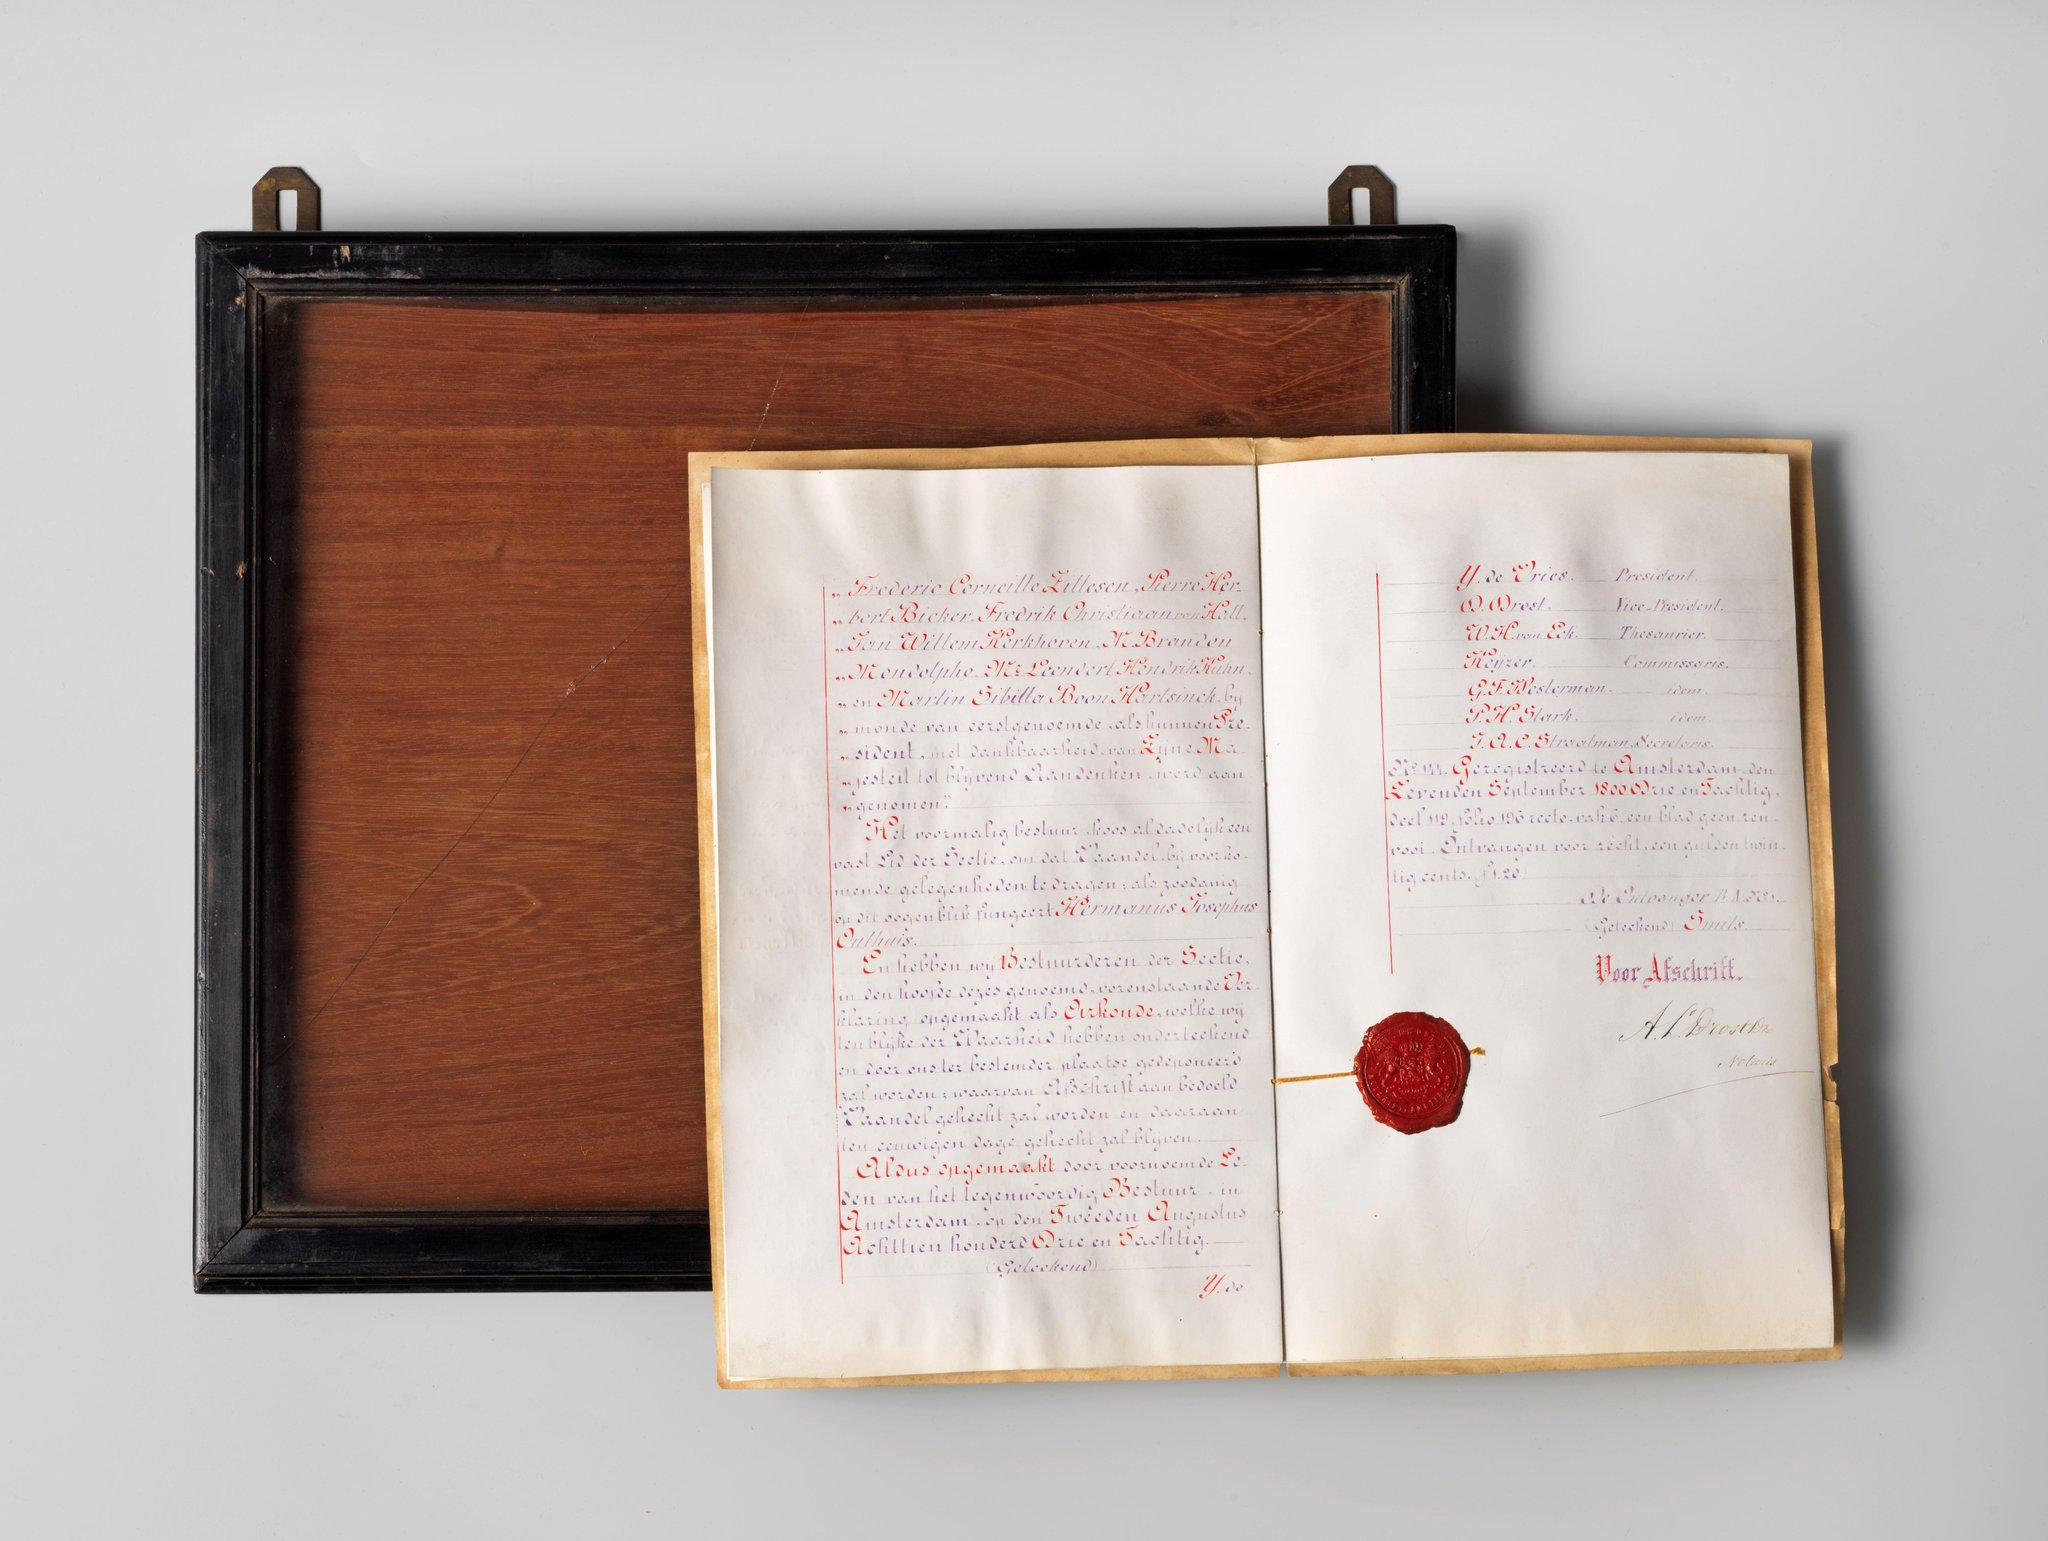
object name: charter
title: Oorkonde en proces verbaal van het vaandel van het regiment der Eerste Sectie van het Metalen Kruis, afdeling Amsterdam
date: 1883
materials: copper, glass, ink, iron, lacquer, oil, paper, parchment, wood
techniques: printing, woodworking, forging, gilding, pen, sewing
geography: amsterdam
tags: amsterdam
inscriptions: date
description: Zwart gelakte houten kist met glazen bovenzijde en zonder bodem, waarin een brede schuiflade met koperen sleutel. De oorkonde en het proces verbaal op perkament in papieren omslag. Geschreven met rode, paarse en zwart inkt, opschrift blz. 4 gedeeltelijk verguld, blz. 7 voorzien van een lakstempel van A. L. Drost, Amsterdam. Gesigneerd: blz. 3 en 7: Smits. Gedateerd: blz. 3 en 7: den Zevenden September 1800 Drie en / Tachtig. Opschrift: blz. 1: Akte van Bewaargeving. Blz. 4: Vereeniging HET METALEN KRUIS etc.